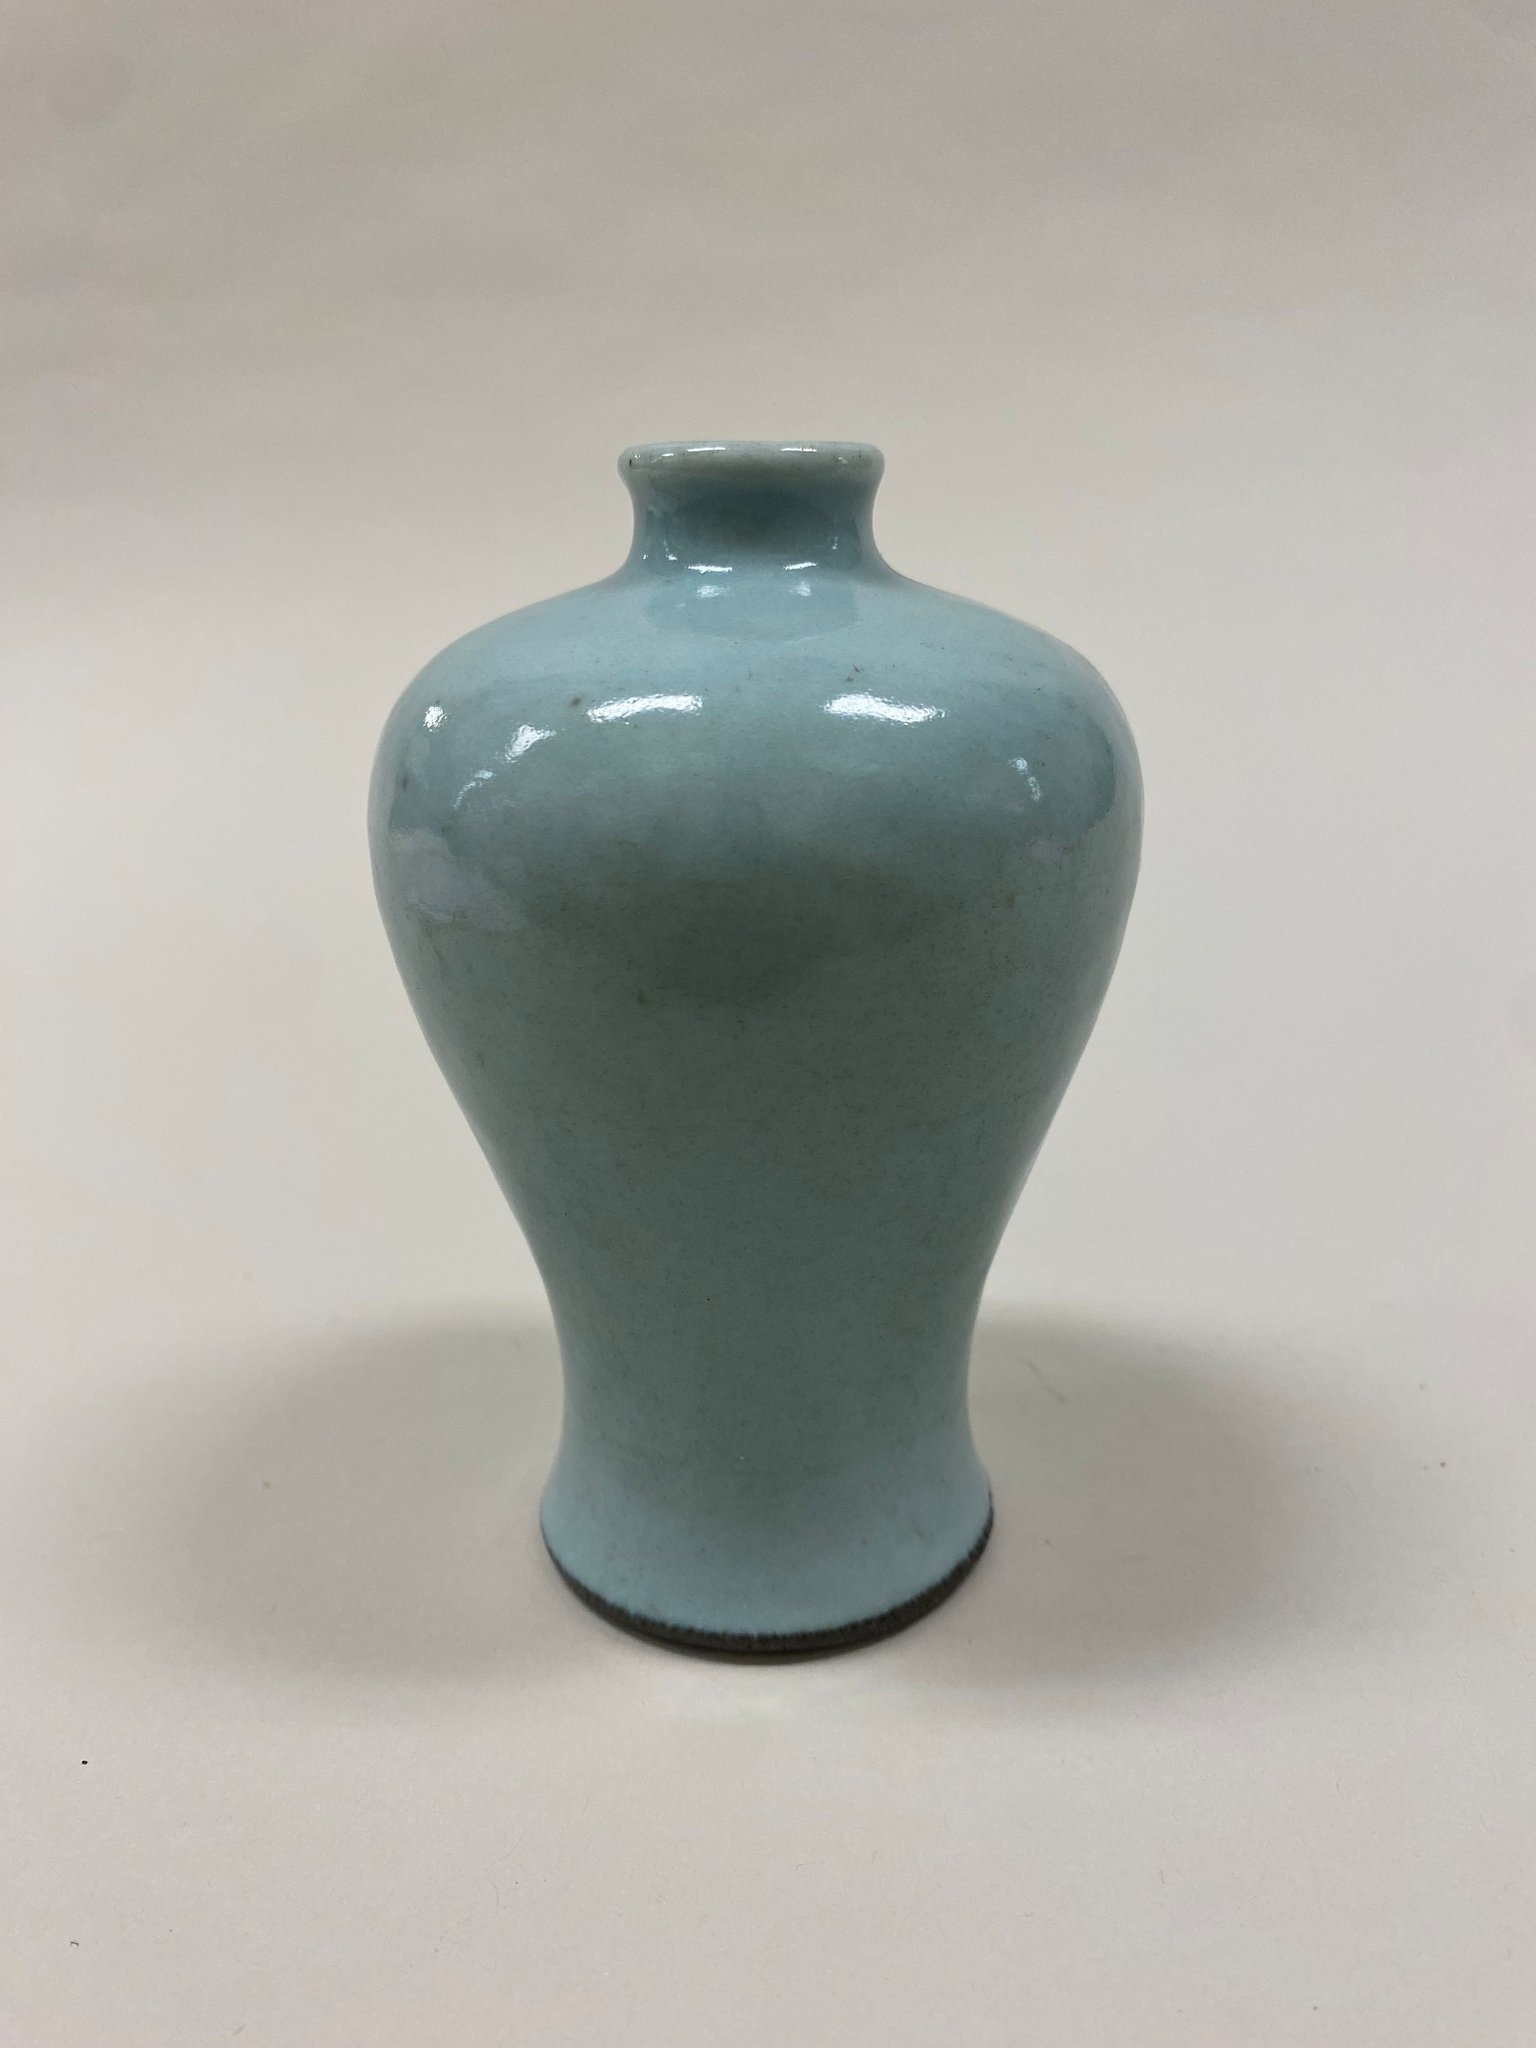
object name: meiping vase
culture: chinese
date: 1701-1800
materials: glaze, porcelain